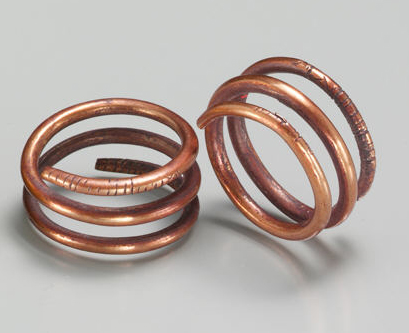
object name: earring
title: Pair of Sprial Earrings (with 16.10.470)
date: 1635-1458 BCE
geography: egypt